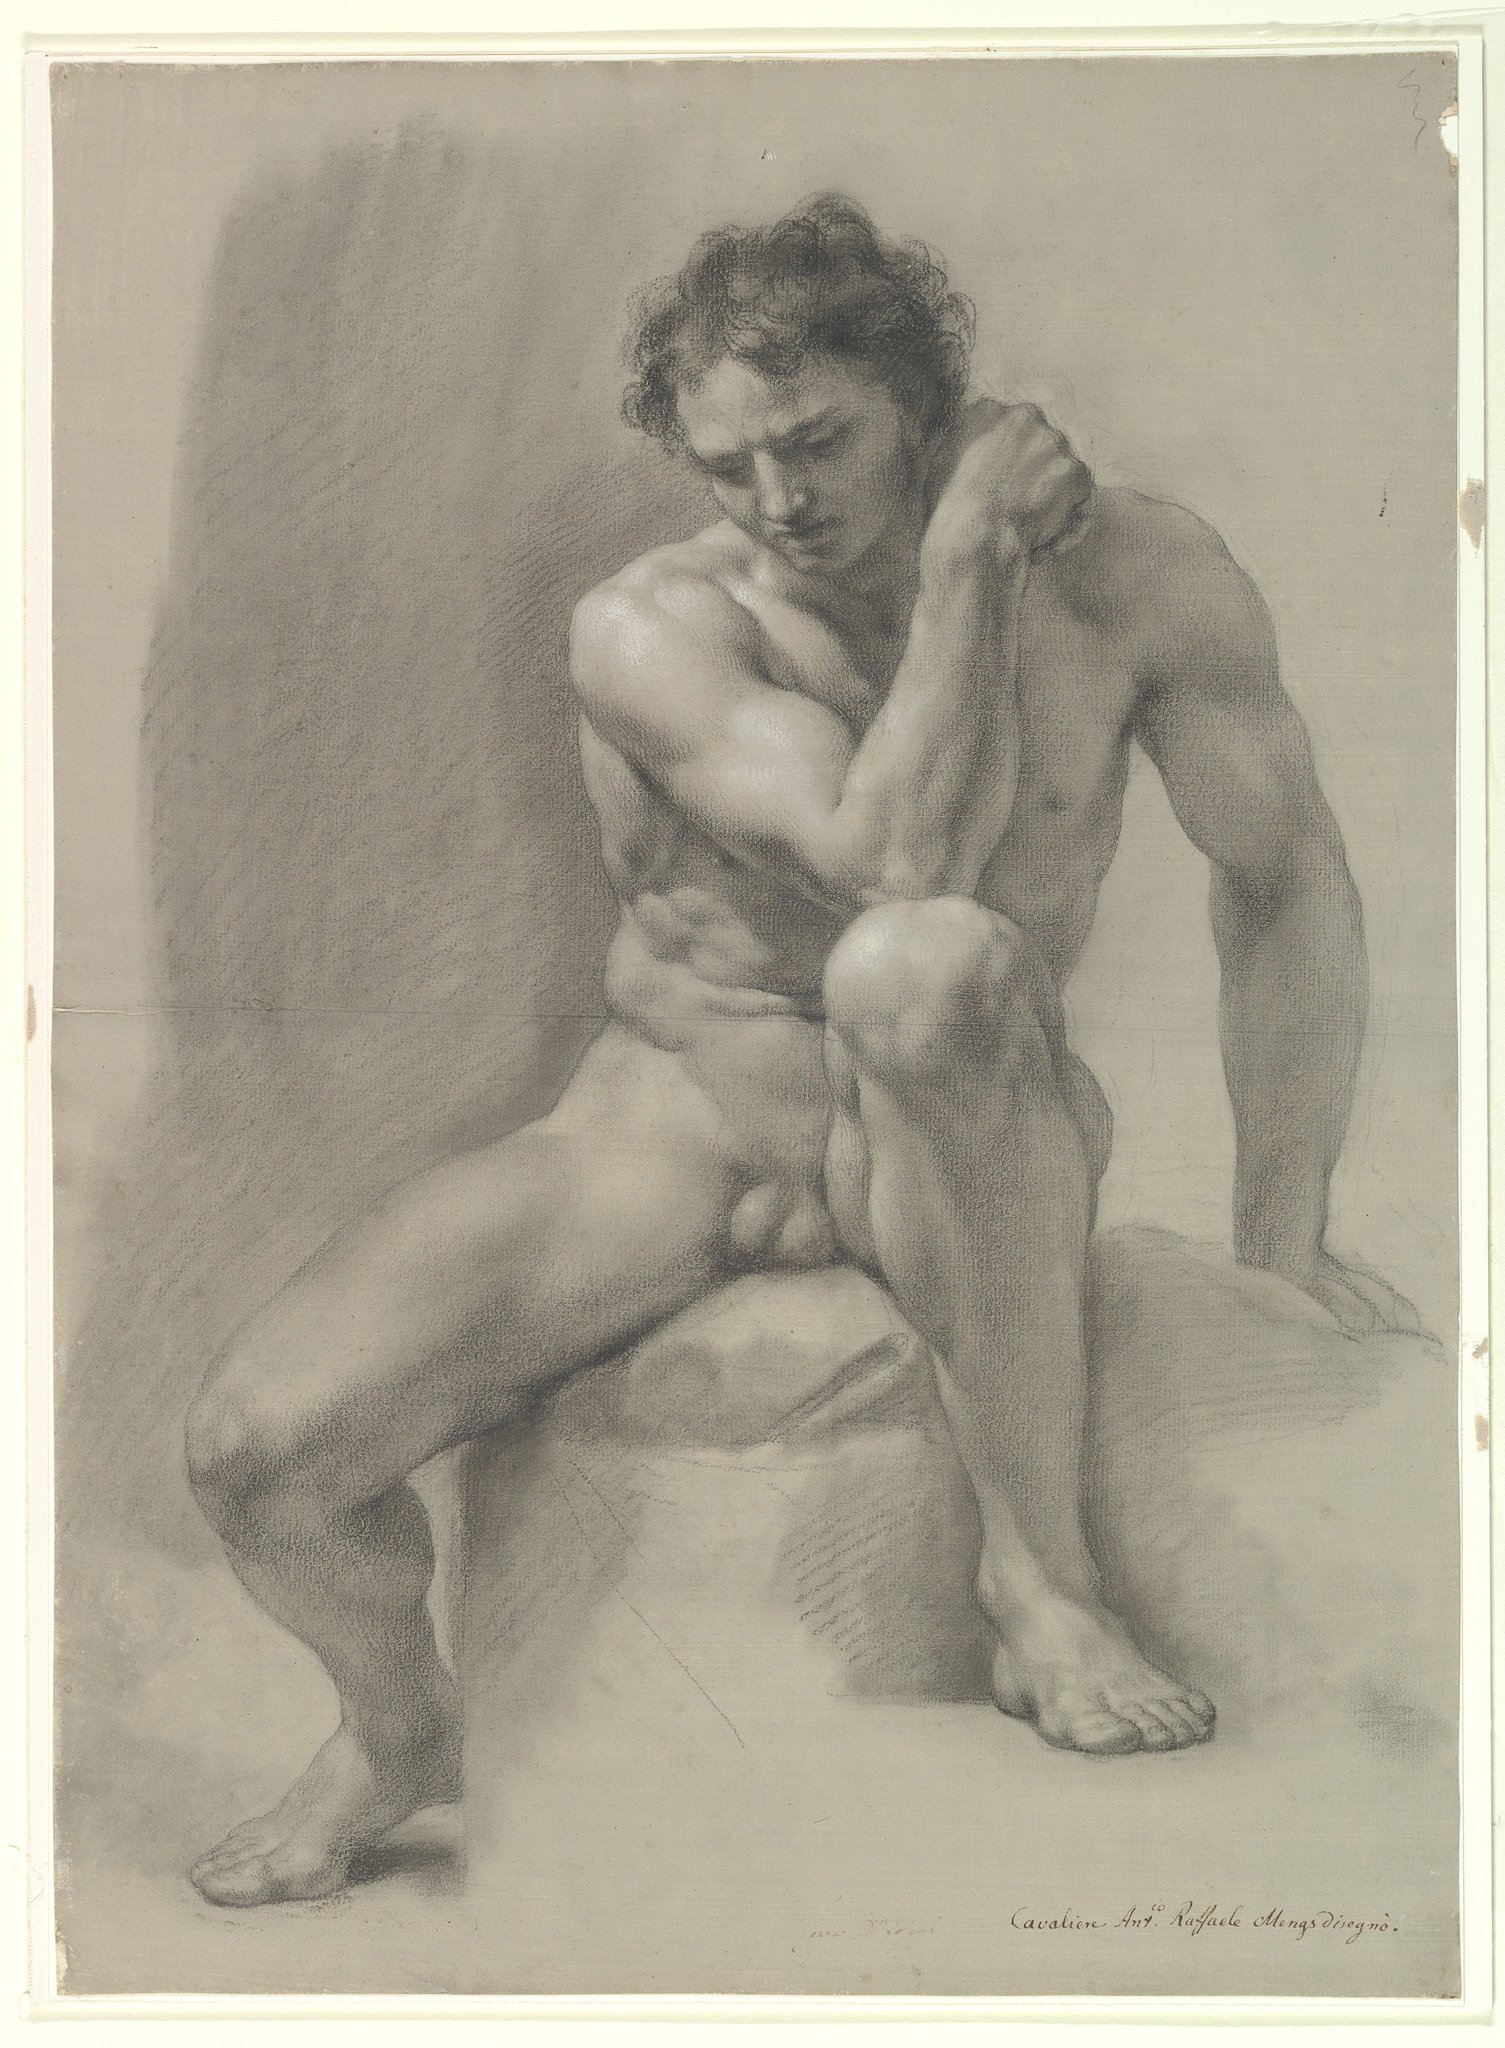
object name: drawing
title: Seated Nude Male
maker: anton raphael mengs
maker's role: artist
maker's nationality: german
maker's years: 1728-1779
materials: chalk, paper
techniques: heightening, wash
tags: male nudes